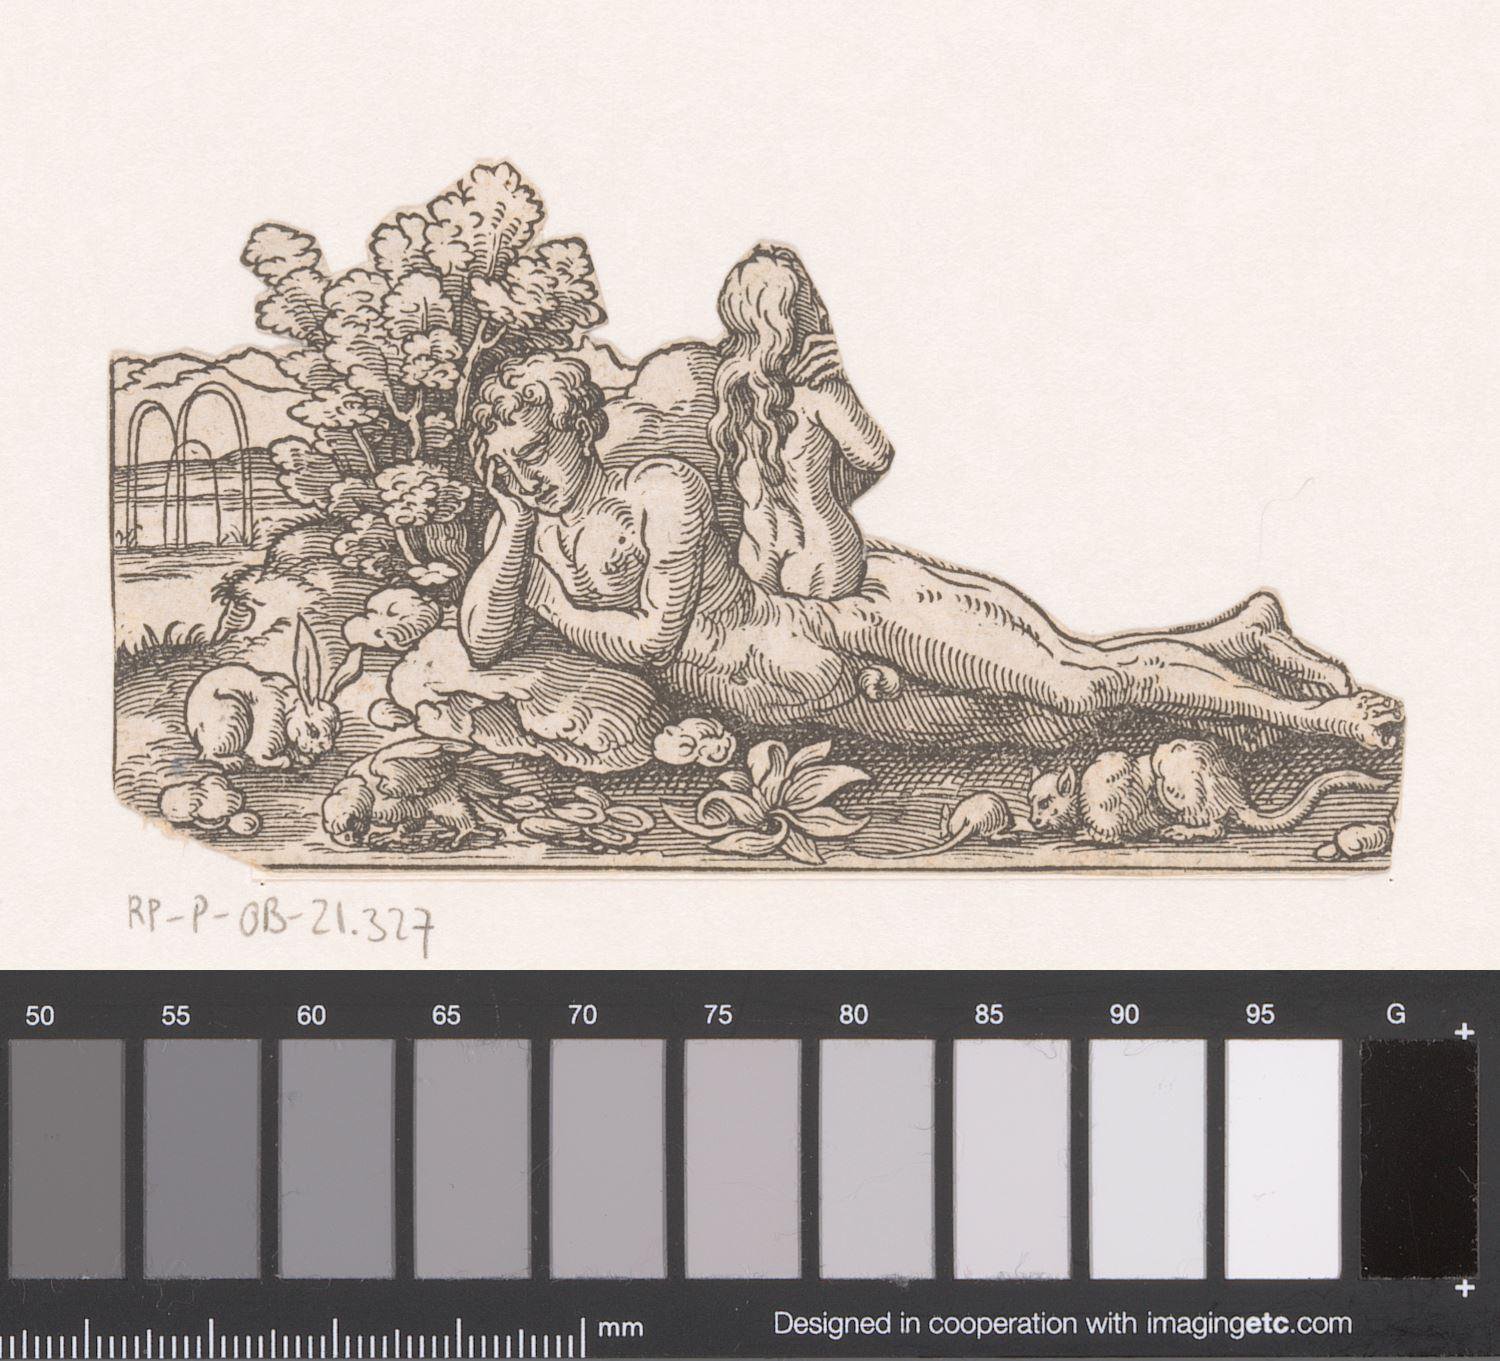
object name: print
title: Schepping van Eva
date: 1565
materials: paper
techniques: woodcut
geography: nuremberg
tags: eve emerges from adam's body, cat and mouse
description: Uitgesneden fragment van een prent afkomstig uit de publicatie: Biblische Figuren dess Alten Testaments. Frankfurt am Main: Johann Wolff, 1565.